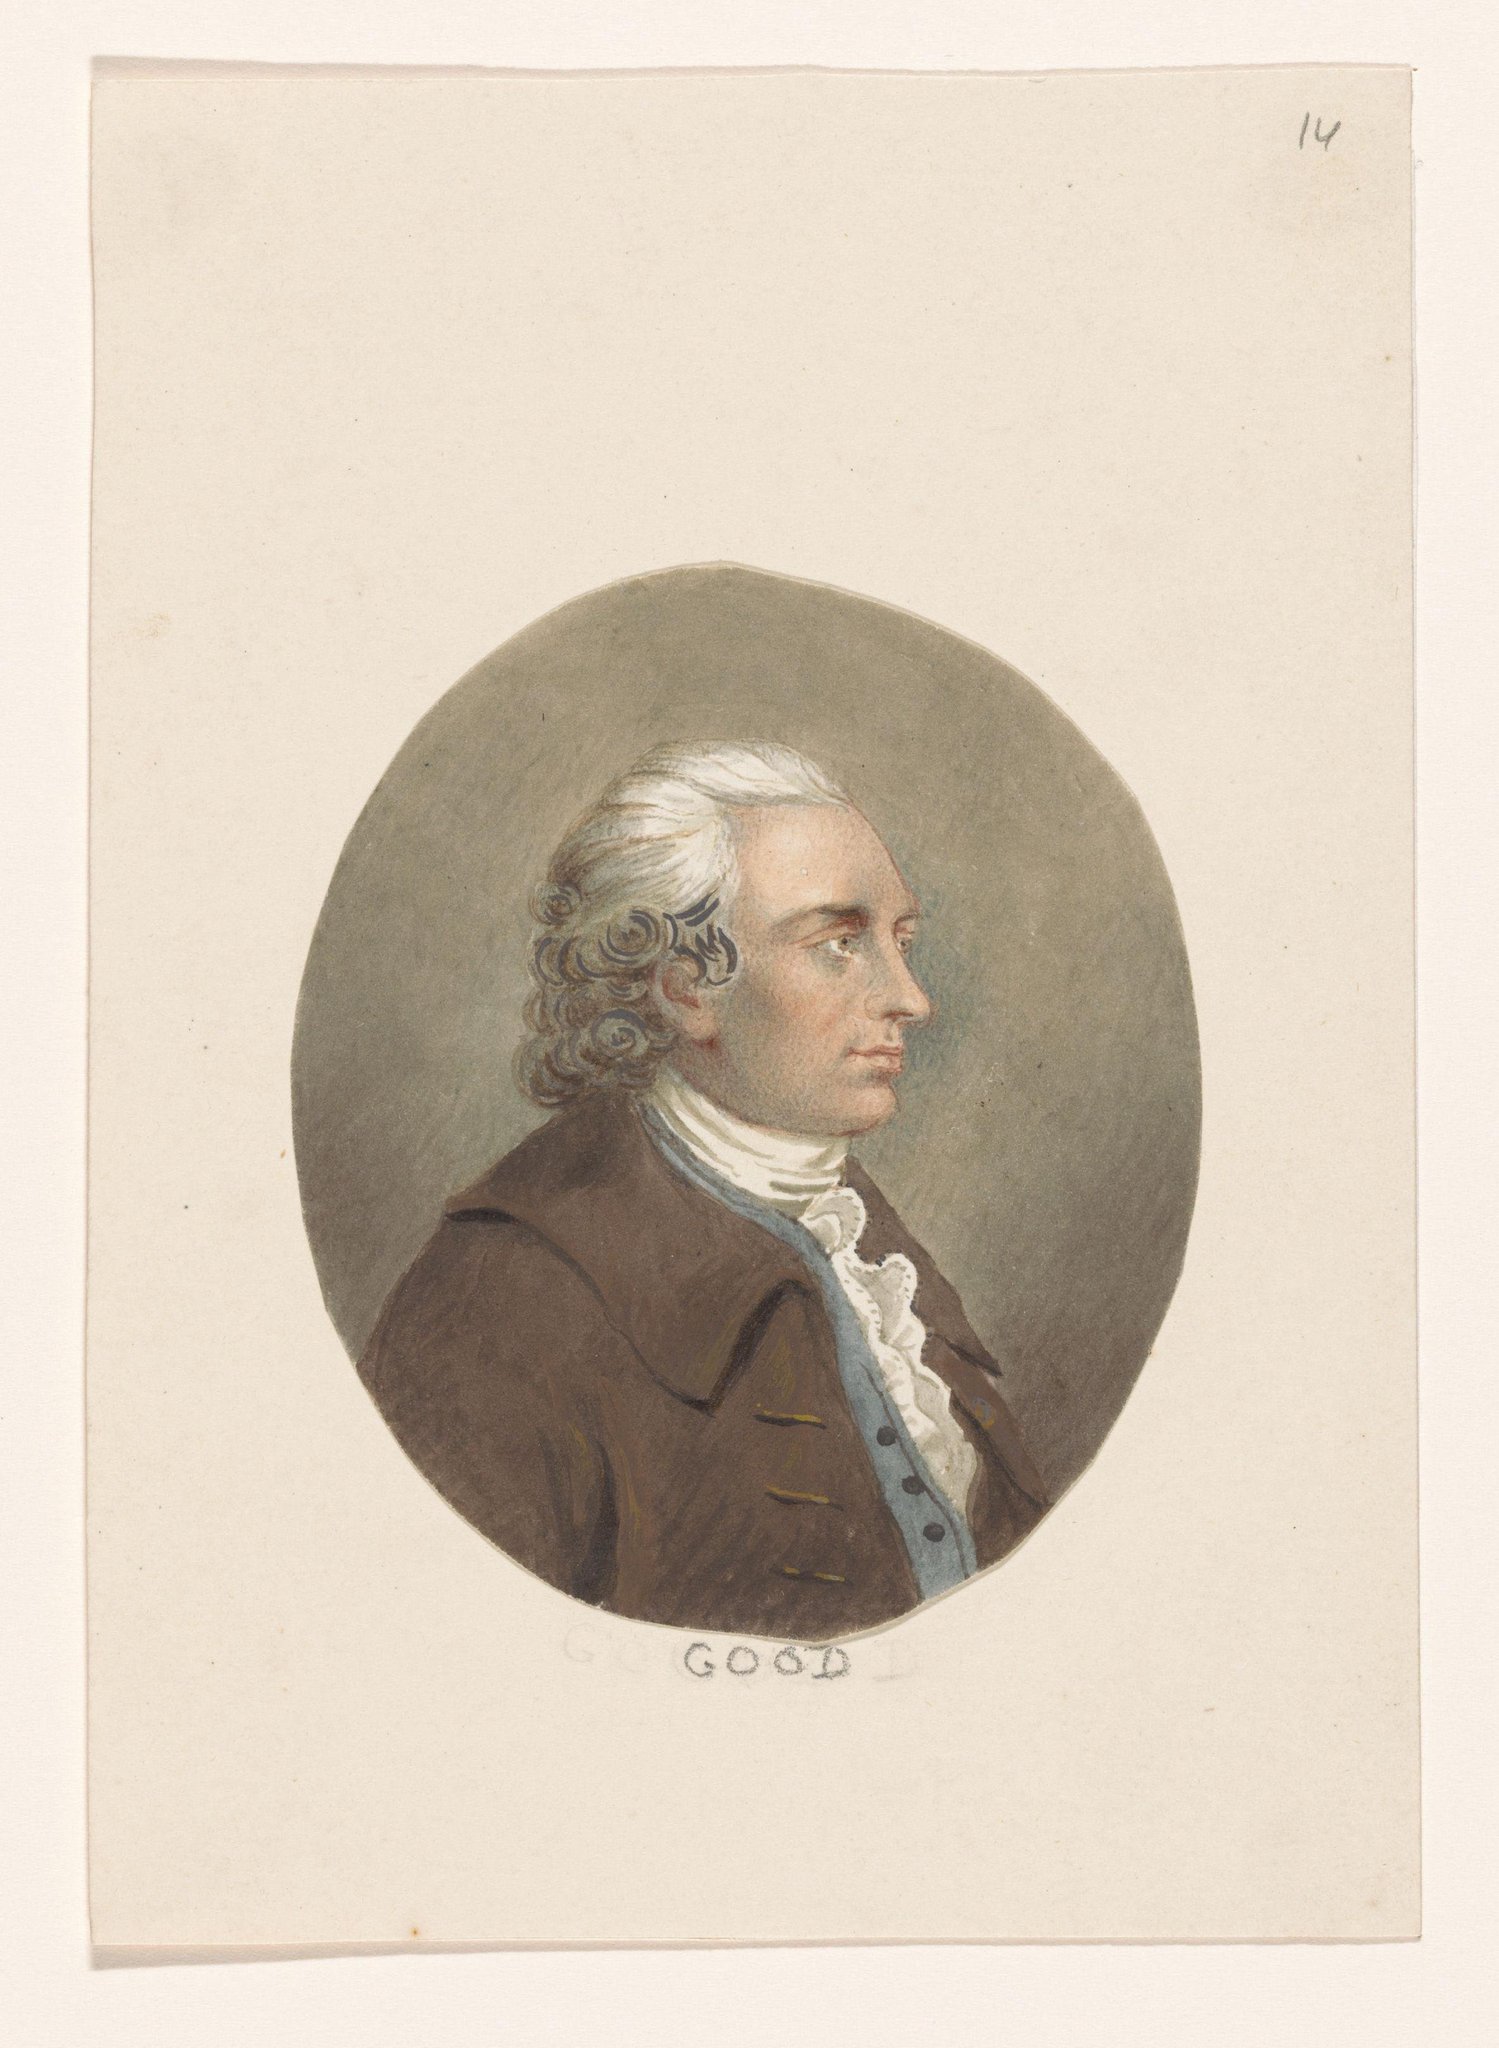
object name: drawing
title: Portret van een onbekende man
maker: Anonymous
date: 1800-1899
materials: paper, watercolor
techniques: brush, snipping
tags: anonymous historical person portrayed, writer, poet, author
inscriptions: collector's mark: Lugt 2228, annotation: ‘Good’